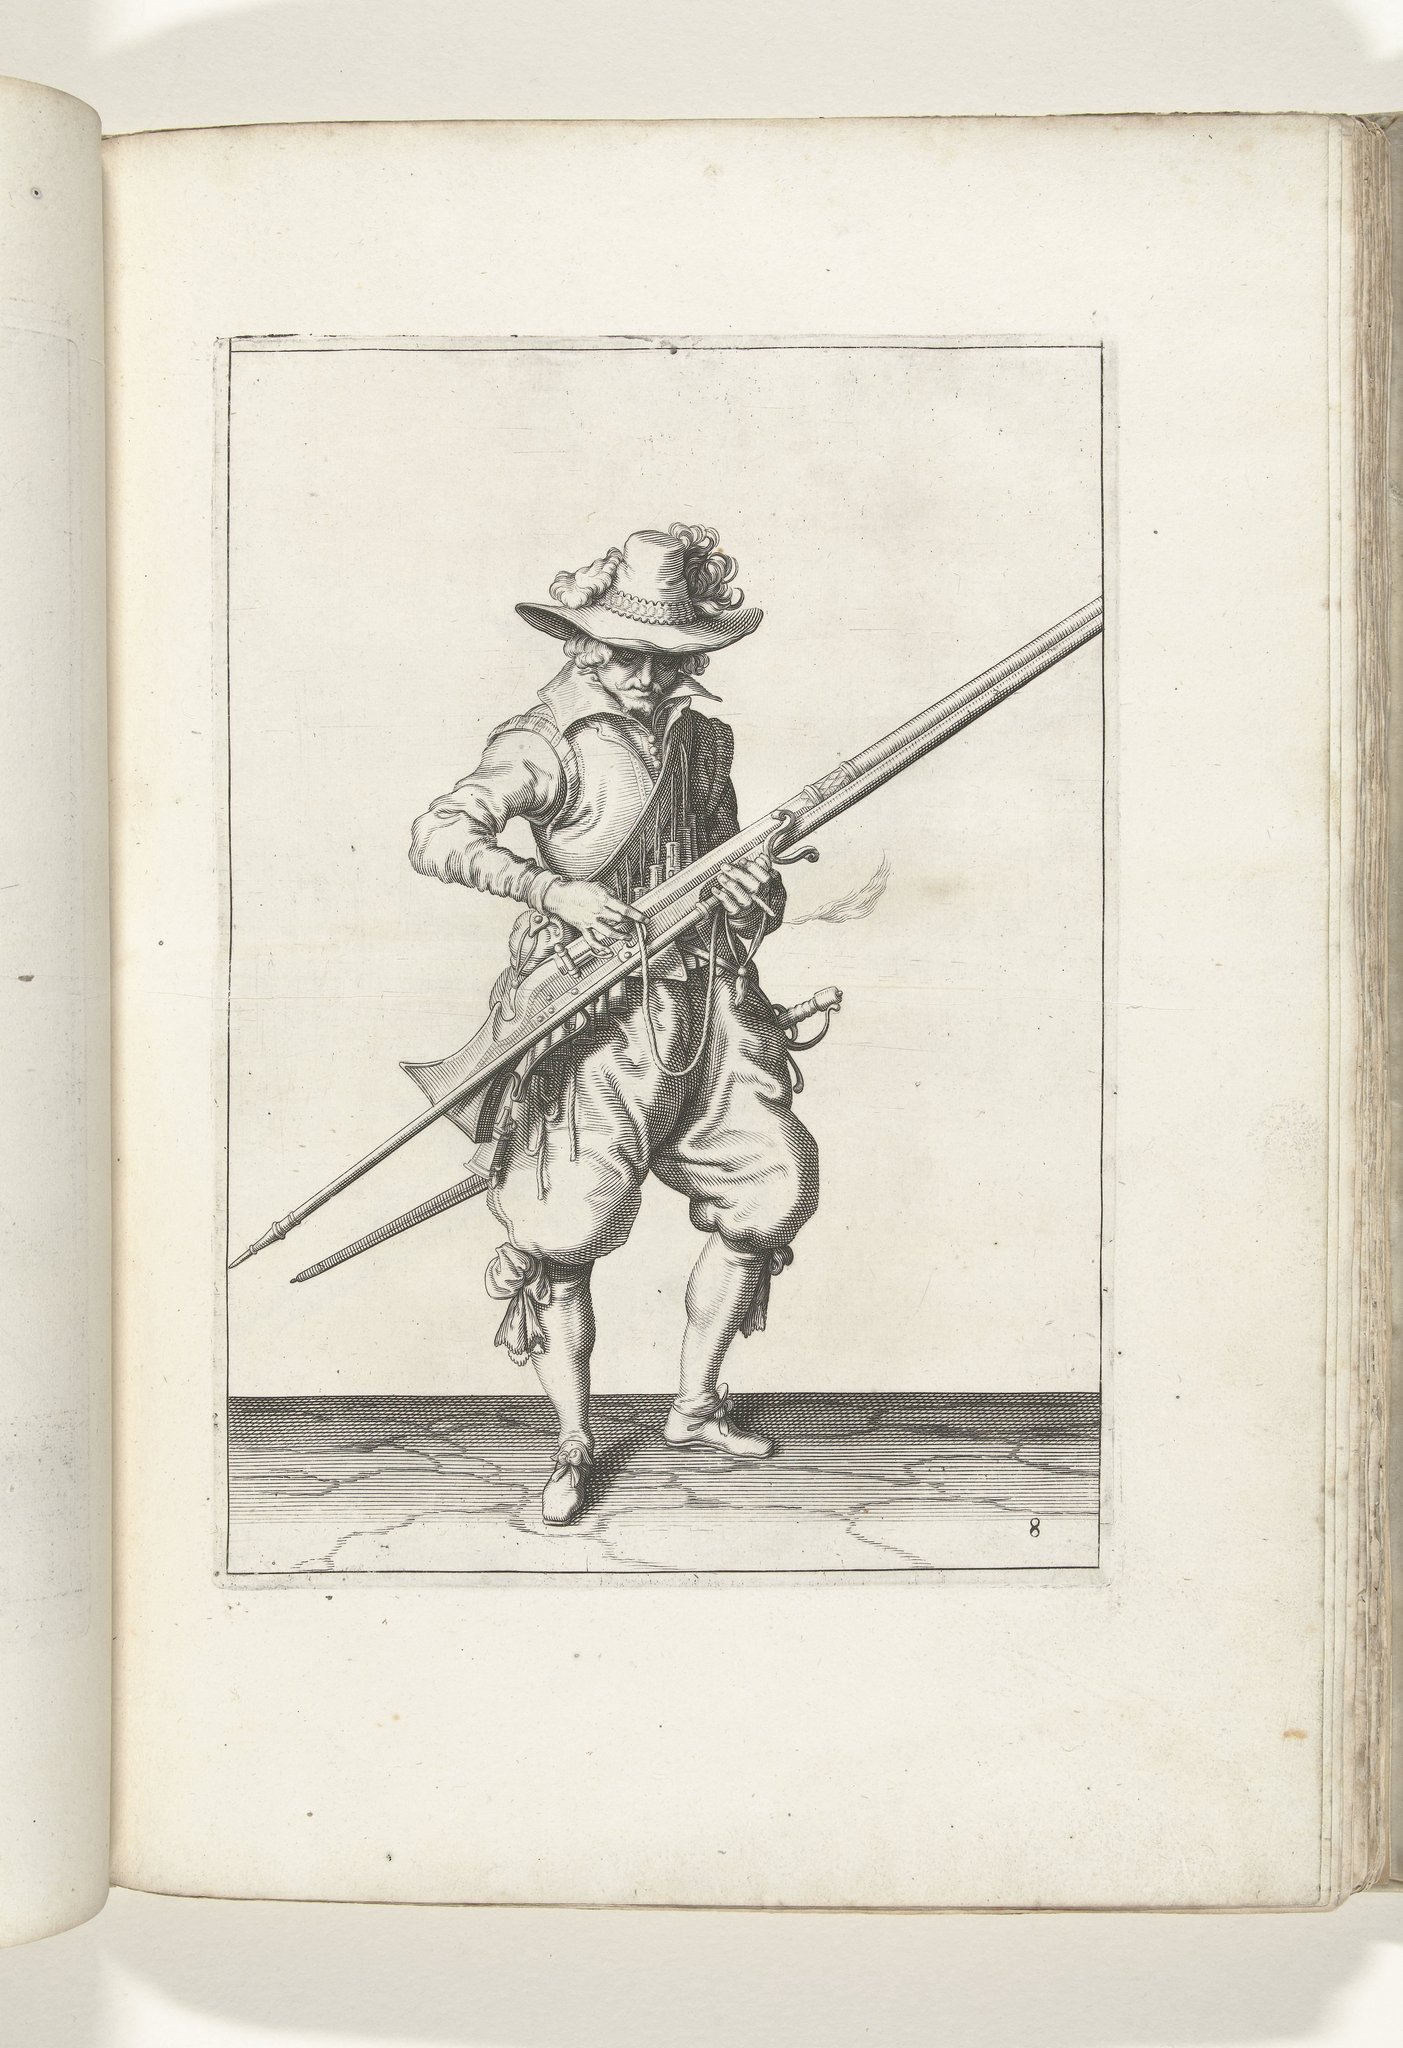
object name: print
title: Soldaat die zijn lont op de haan van zijn musket drukt (nr. 8), ca. 1600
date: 1597-1607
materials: paper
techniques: engraving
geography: the hague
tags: the hague, maurice (prince of orange), handling of weapons ~ military training, weapons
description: Een soldaat, ten voeten uit, naar rechts, die een musket (een bepaald type vuurwapen) met zijn linkerhand vasthoudt (nr. 8), ca. 1600. Met zijn rechterhand drukt hij een brandende lont op de haan (onderdeel van het ontstekingsmechanisme) van zijn musket. Plaat 8 in de instructies voor het hanteren van het musket: Corte onderrechtinghe op de figuerliicke afbeeldinghe, soo veel aengaet het recht ghebruyck vant Musquet. Onderdeel van de illustraties in: J. de Gheyn, Wapenhandelinghe van Roers Musquetten ende spiessen, 's-Gravenhage, 1607. Krijgswezen rond 1600.